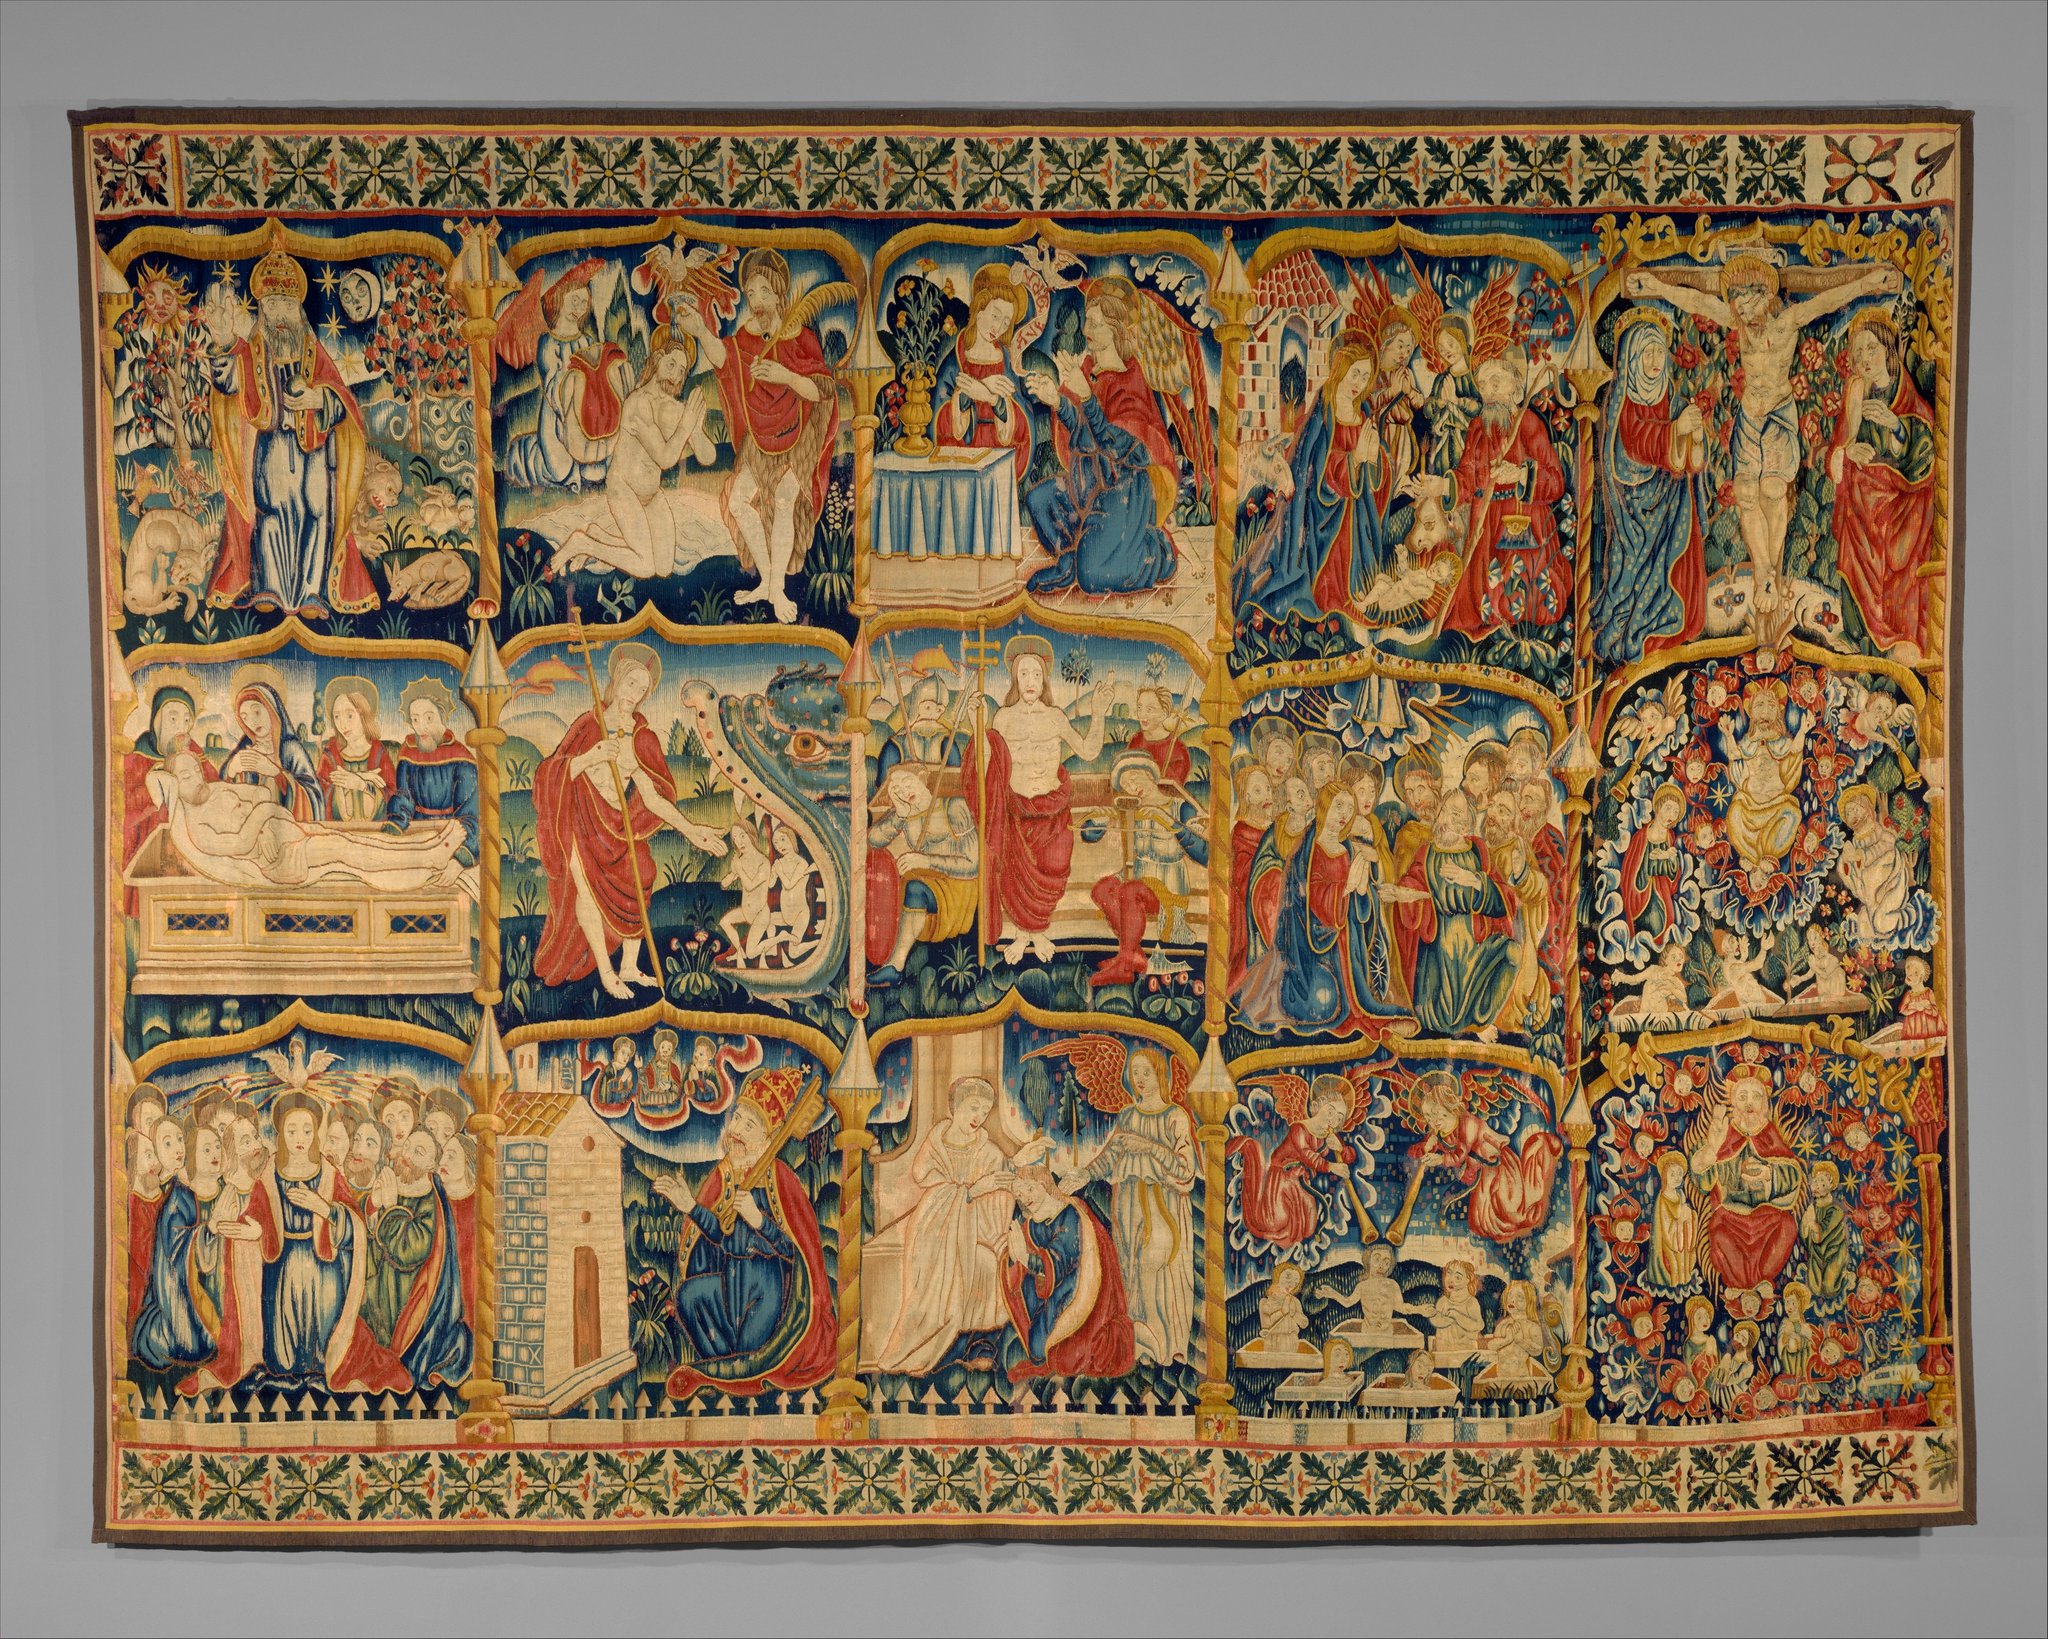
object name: tapestry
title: The Apostles Creed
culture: european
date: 1550-1600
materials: wool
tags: men,women,angels,cross